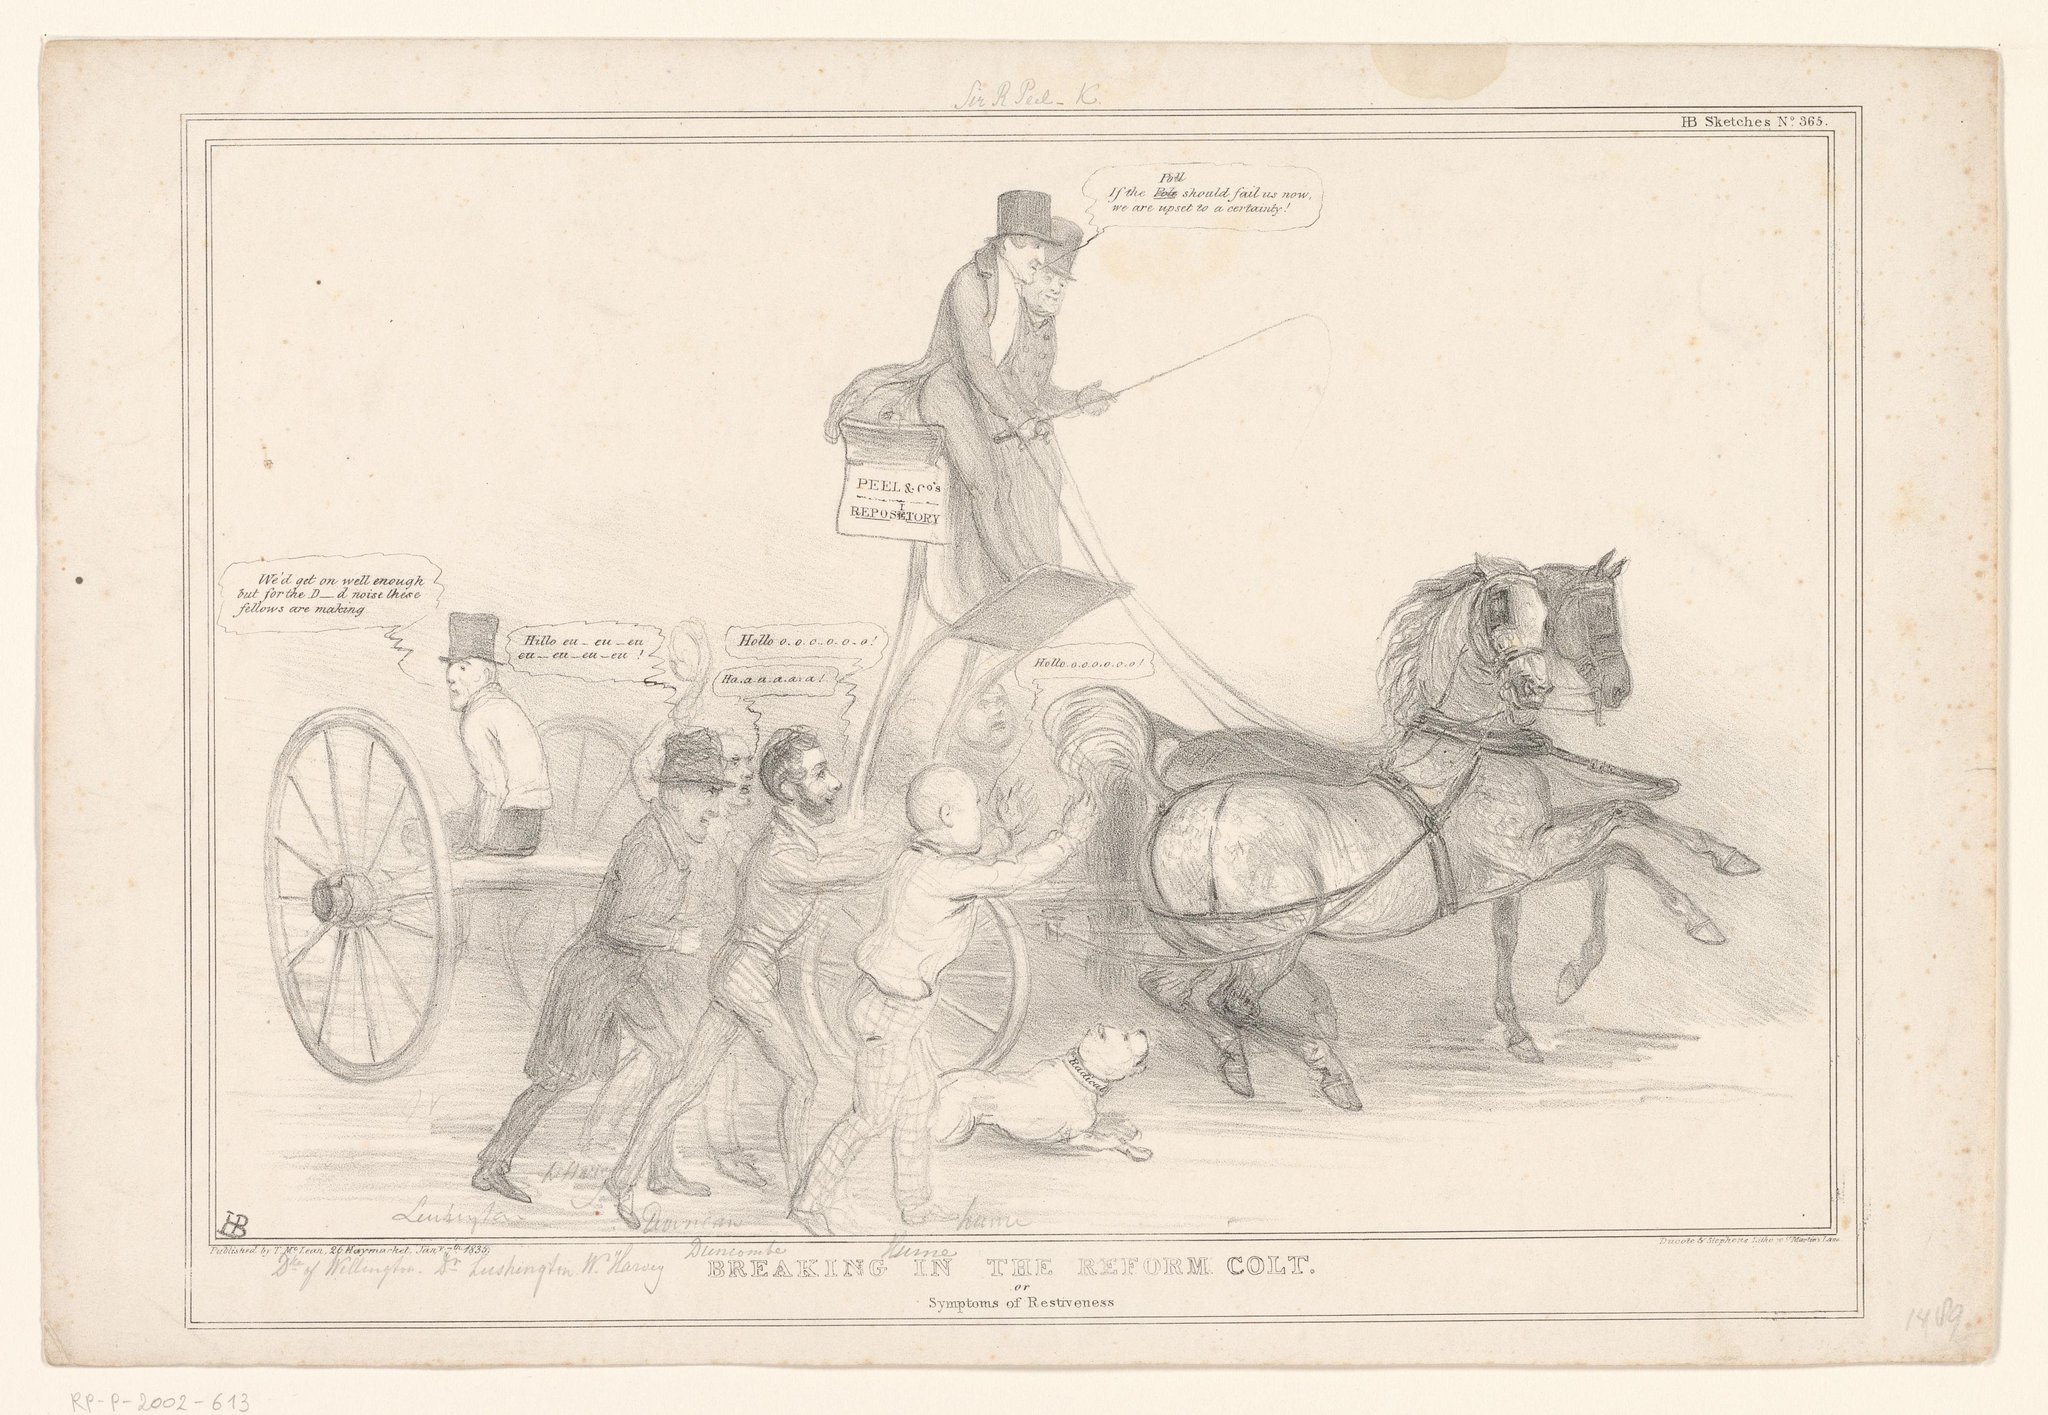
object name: cartoon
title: Breaking in the Reform Colt. or Symptoms of Restiveness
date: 1835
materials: paper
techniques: lithograph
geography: london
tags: london, walmer castle, arthur wellesley of wellington, willem iv hendrik (koning van het verenigd koninkrijk en hannover), four-wheeled vehicle drawn by two animals, political caricatures and satires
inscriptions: collector's mark: Lugt 2228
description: Spotprent op Sir Robert Peel die als koetsier samen met de koning Willem IV een wagen bestuurt, achterop zit Wellington. Uitgegeven als nr. 365 in de serie HB Sketches.